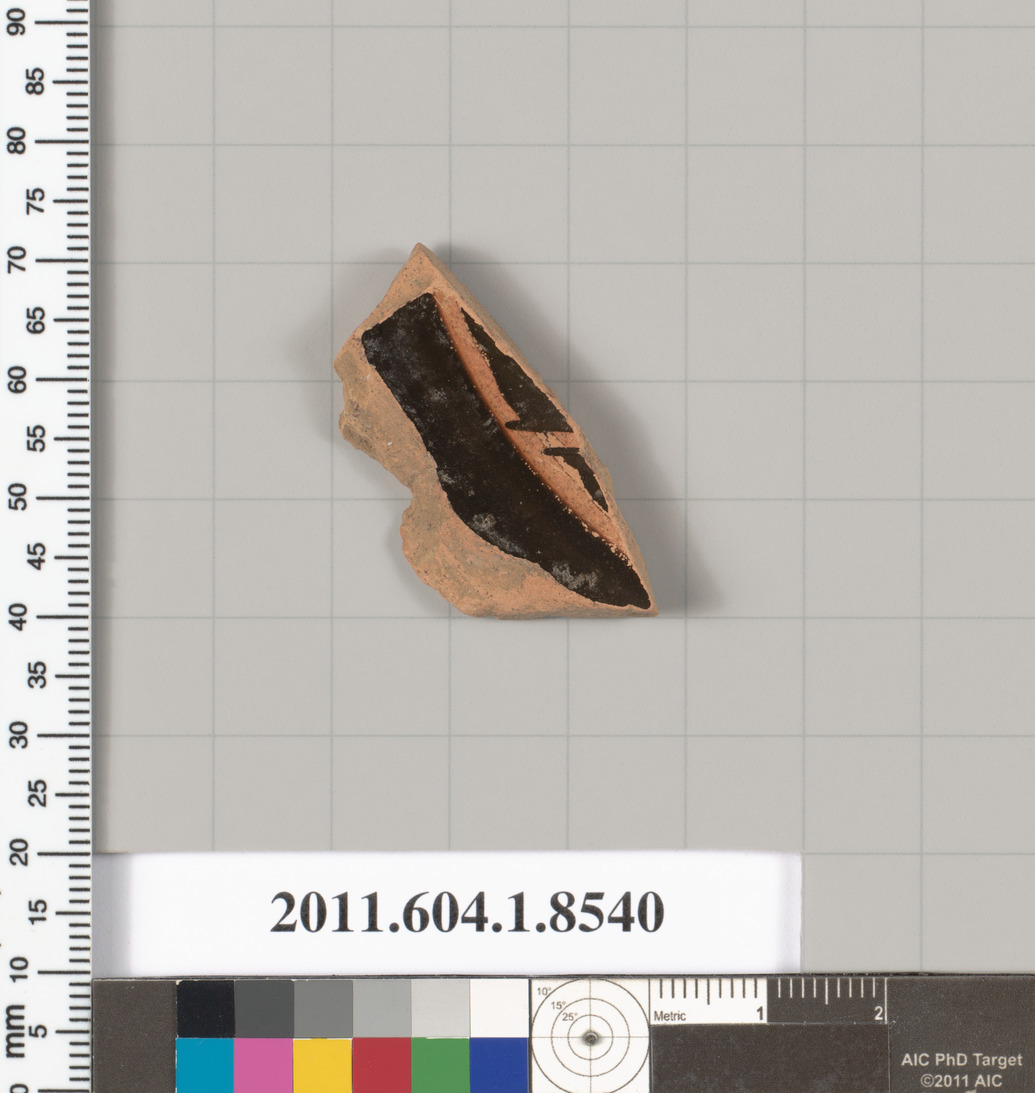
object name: kylix fragment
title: Terracotta fragment of a stemless kylix (drinking cup)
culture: greek, attic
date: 467-435 BCE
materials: terracotta